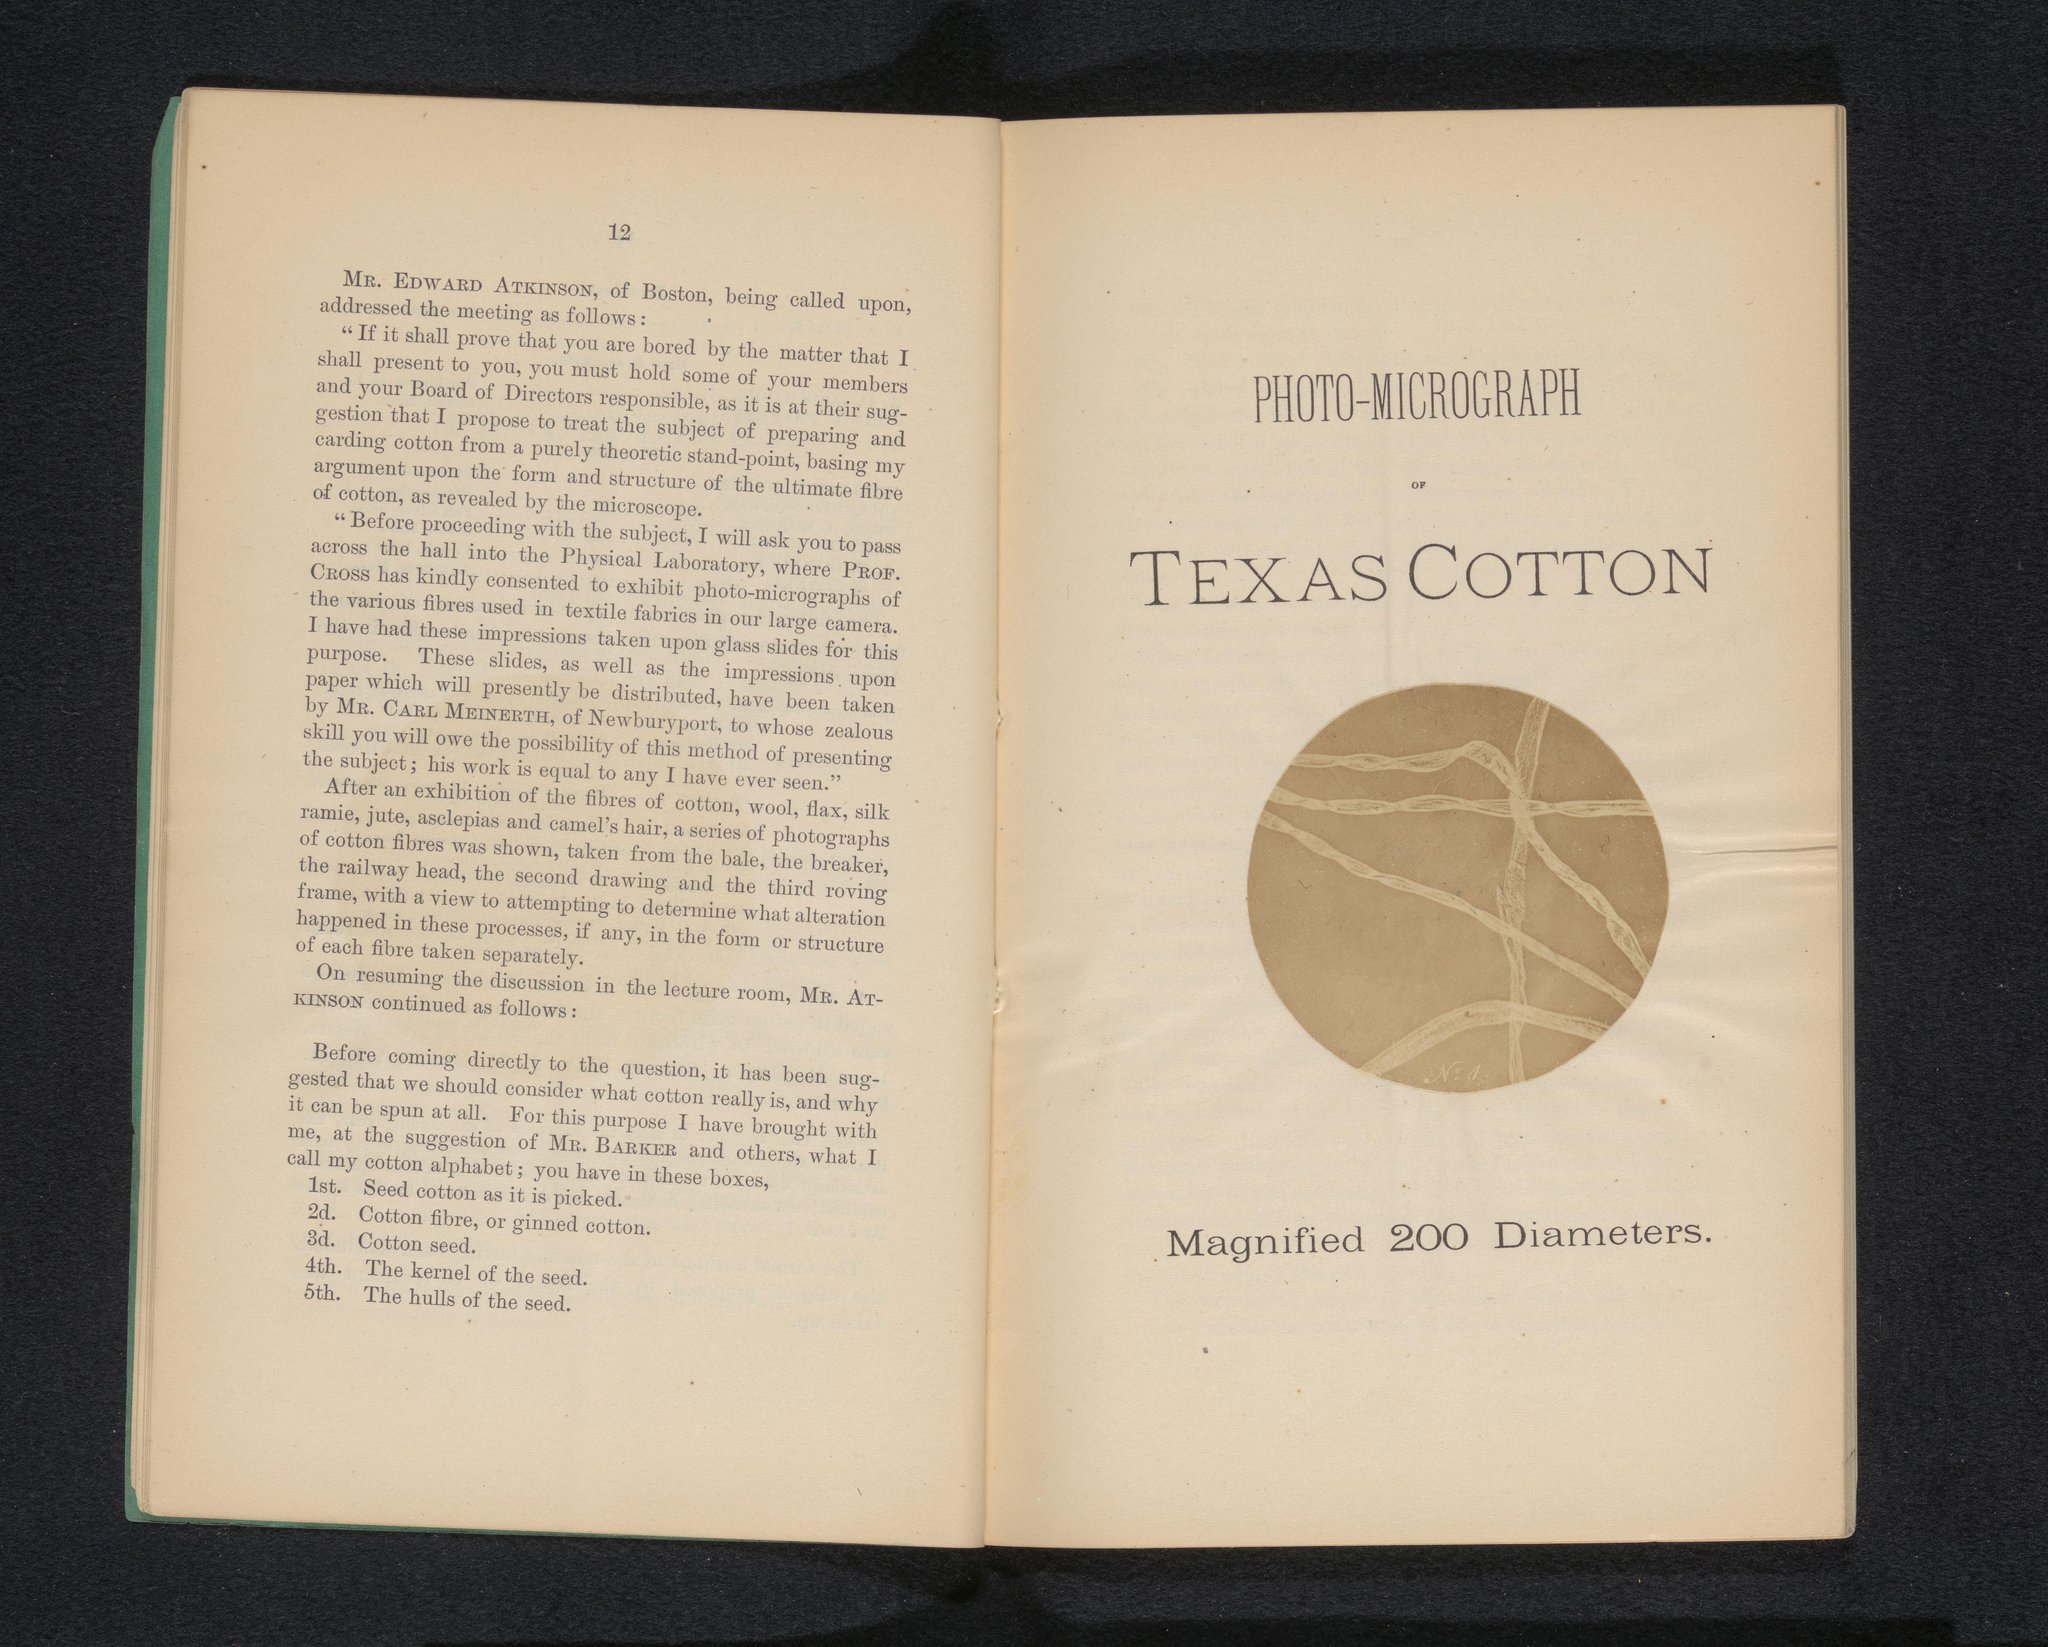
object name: photograph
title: Photo-micrograph of Texas Cotton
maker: Anonymous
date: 1869-1874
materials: paper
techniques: albumen print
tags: cotton (material ~ textile industry)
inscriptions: inscription: ‘Magnified 200 diameters’